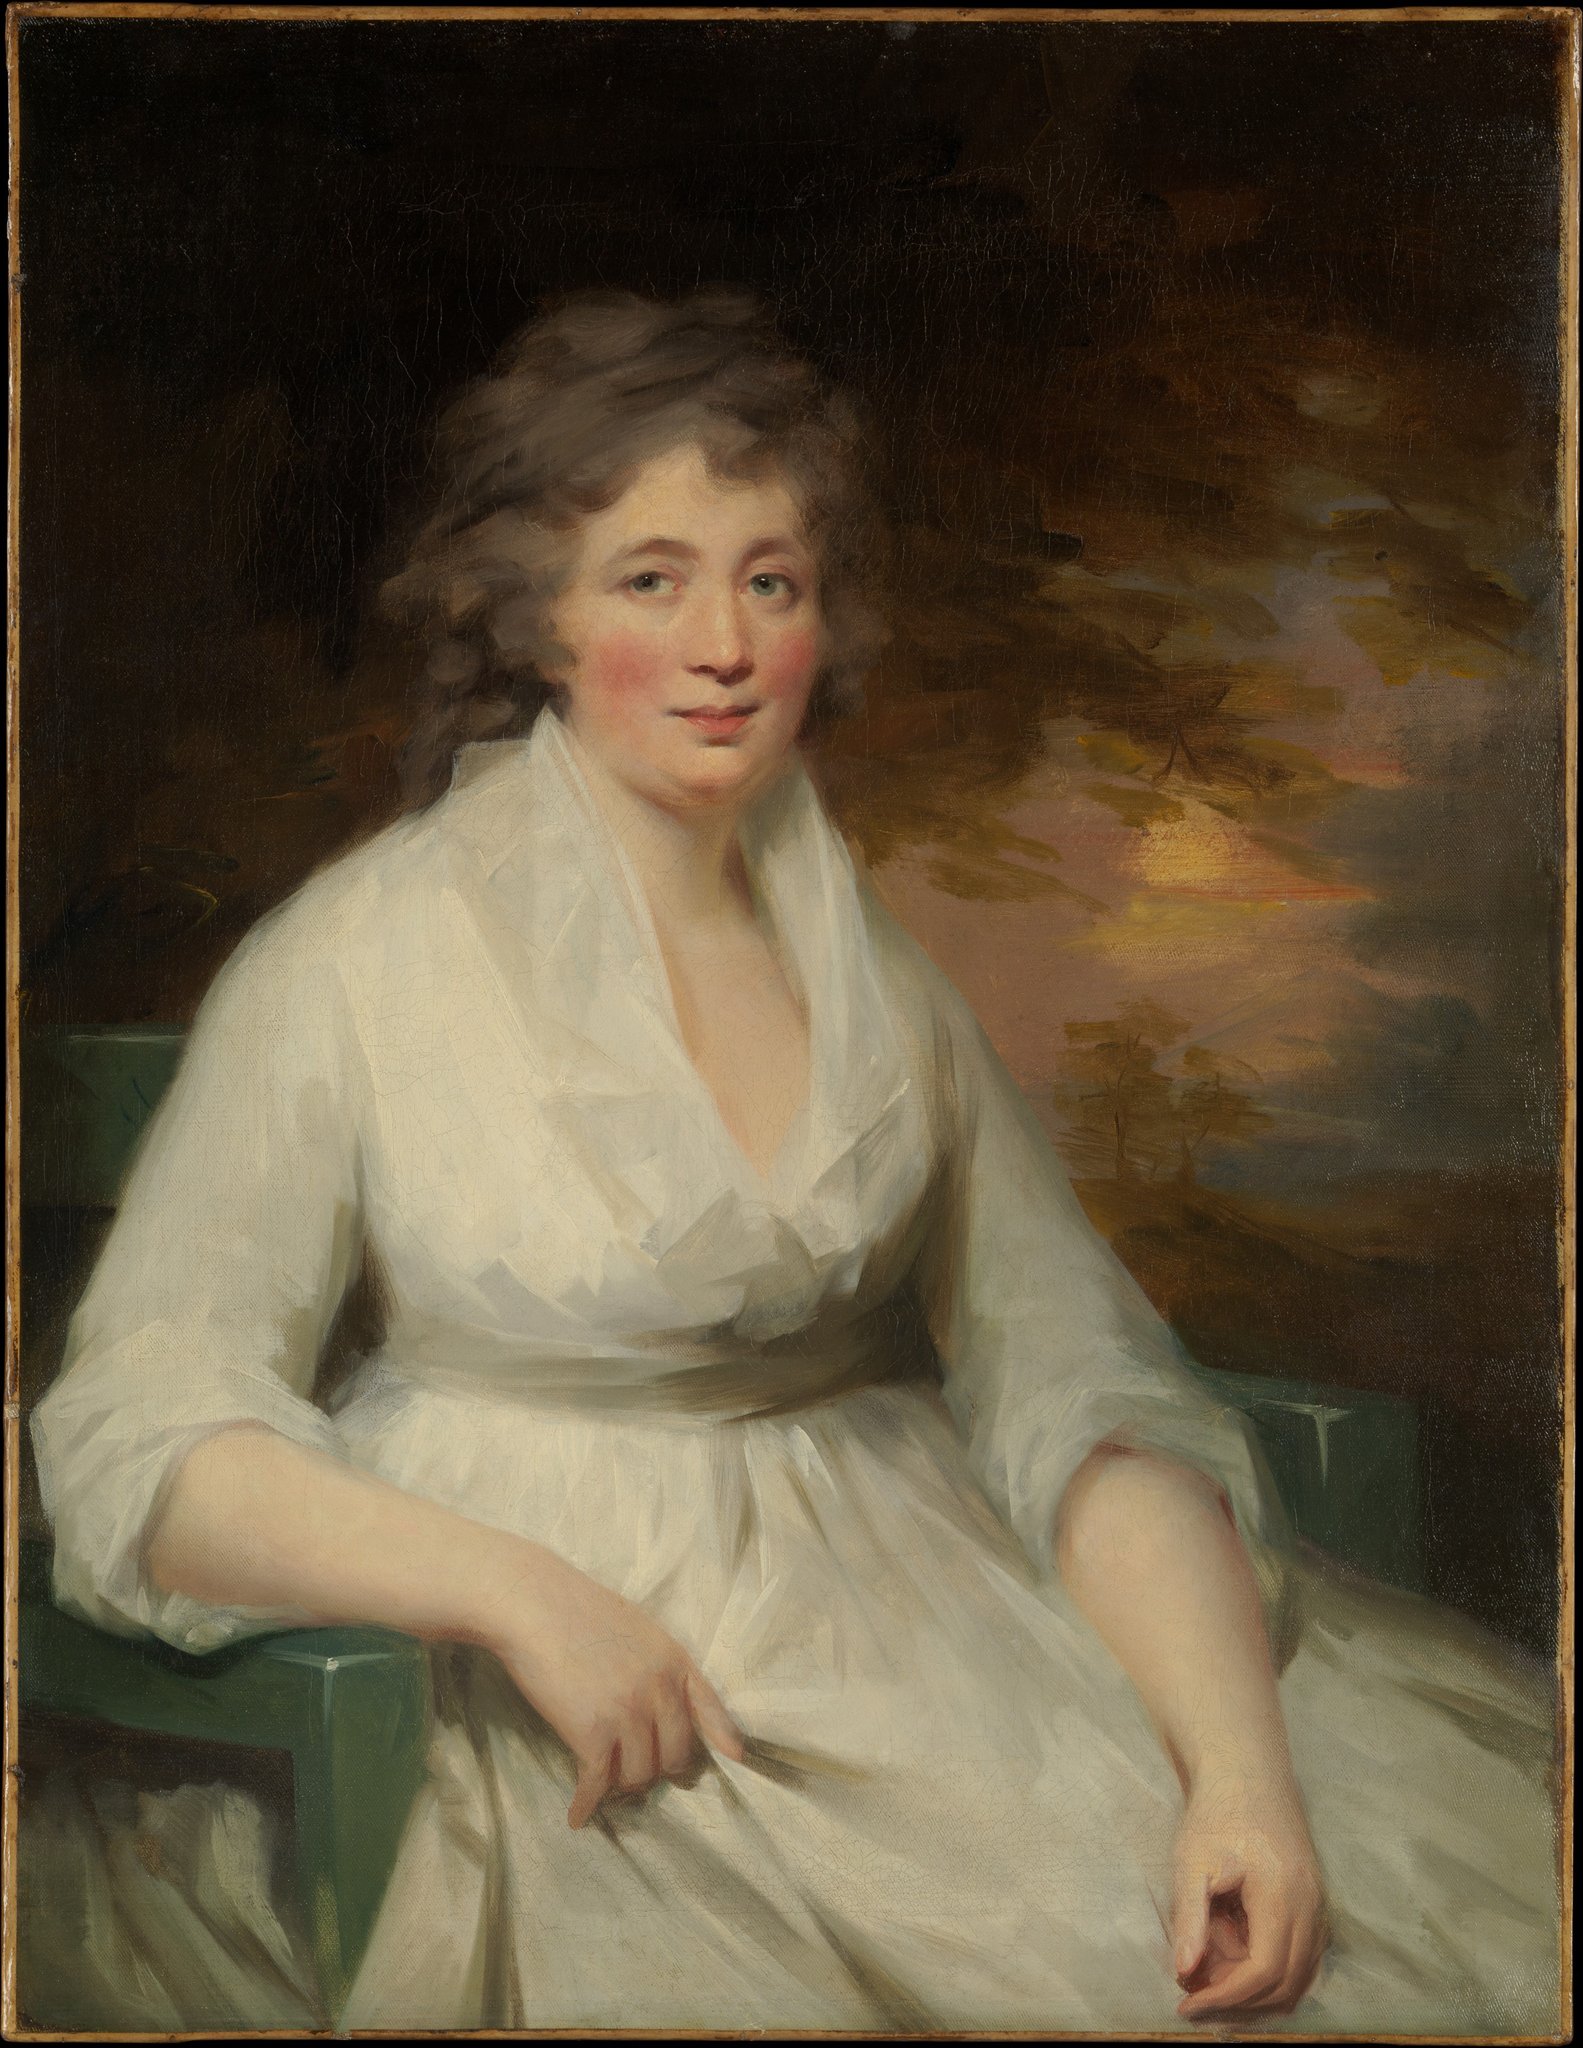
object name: painting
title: Janet Law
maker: sir henry raeburn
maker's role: artist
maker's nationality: british, scottish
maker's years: 1756-1923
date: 1776-1823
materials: canvas, oil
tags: portraits,women